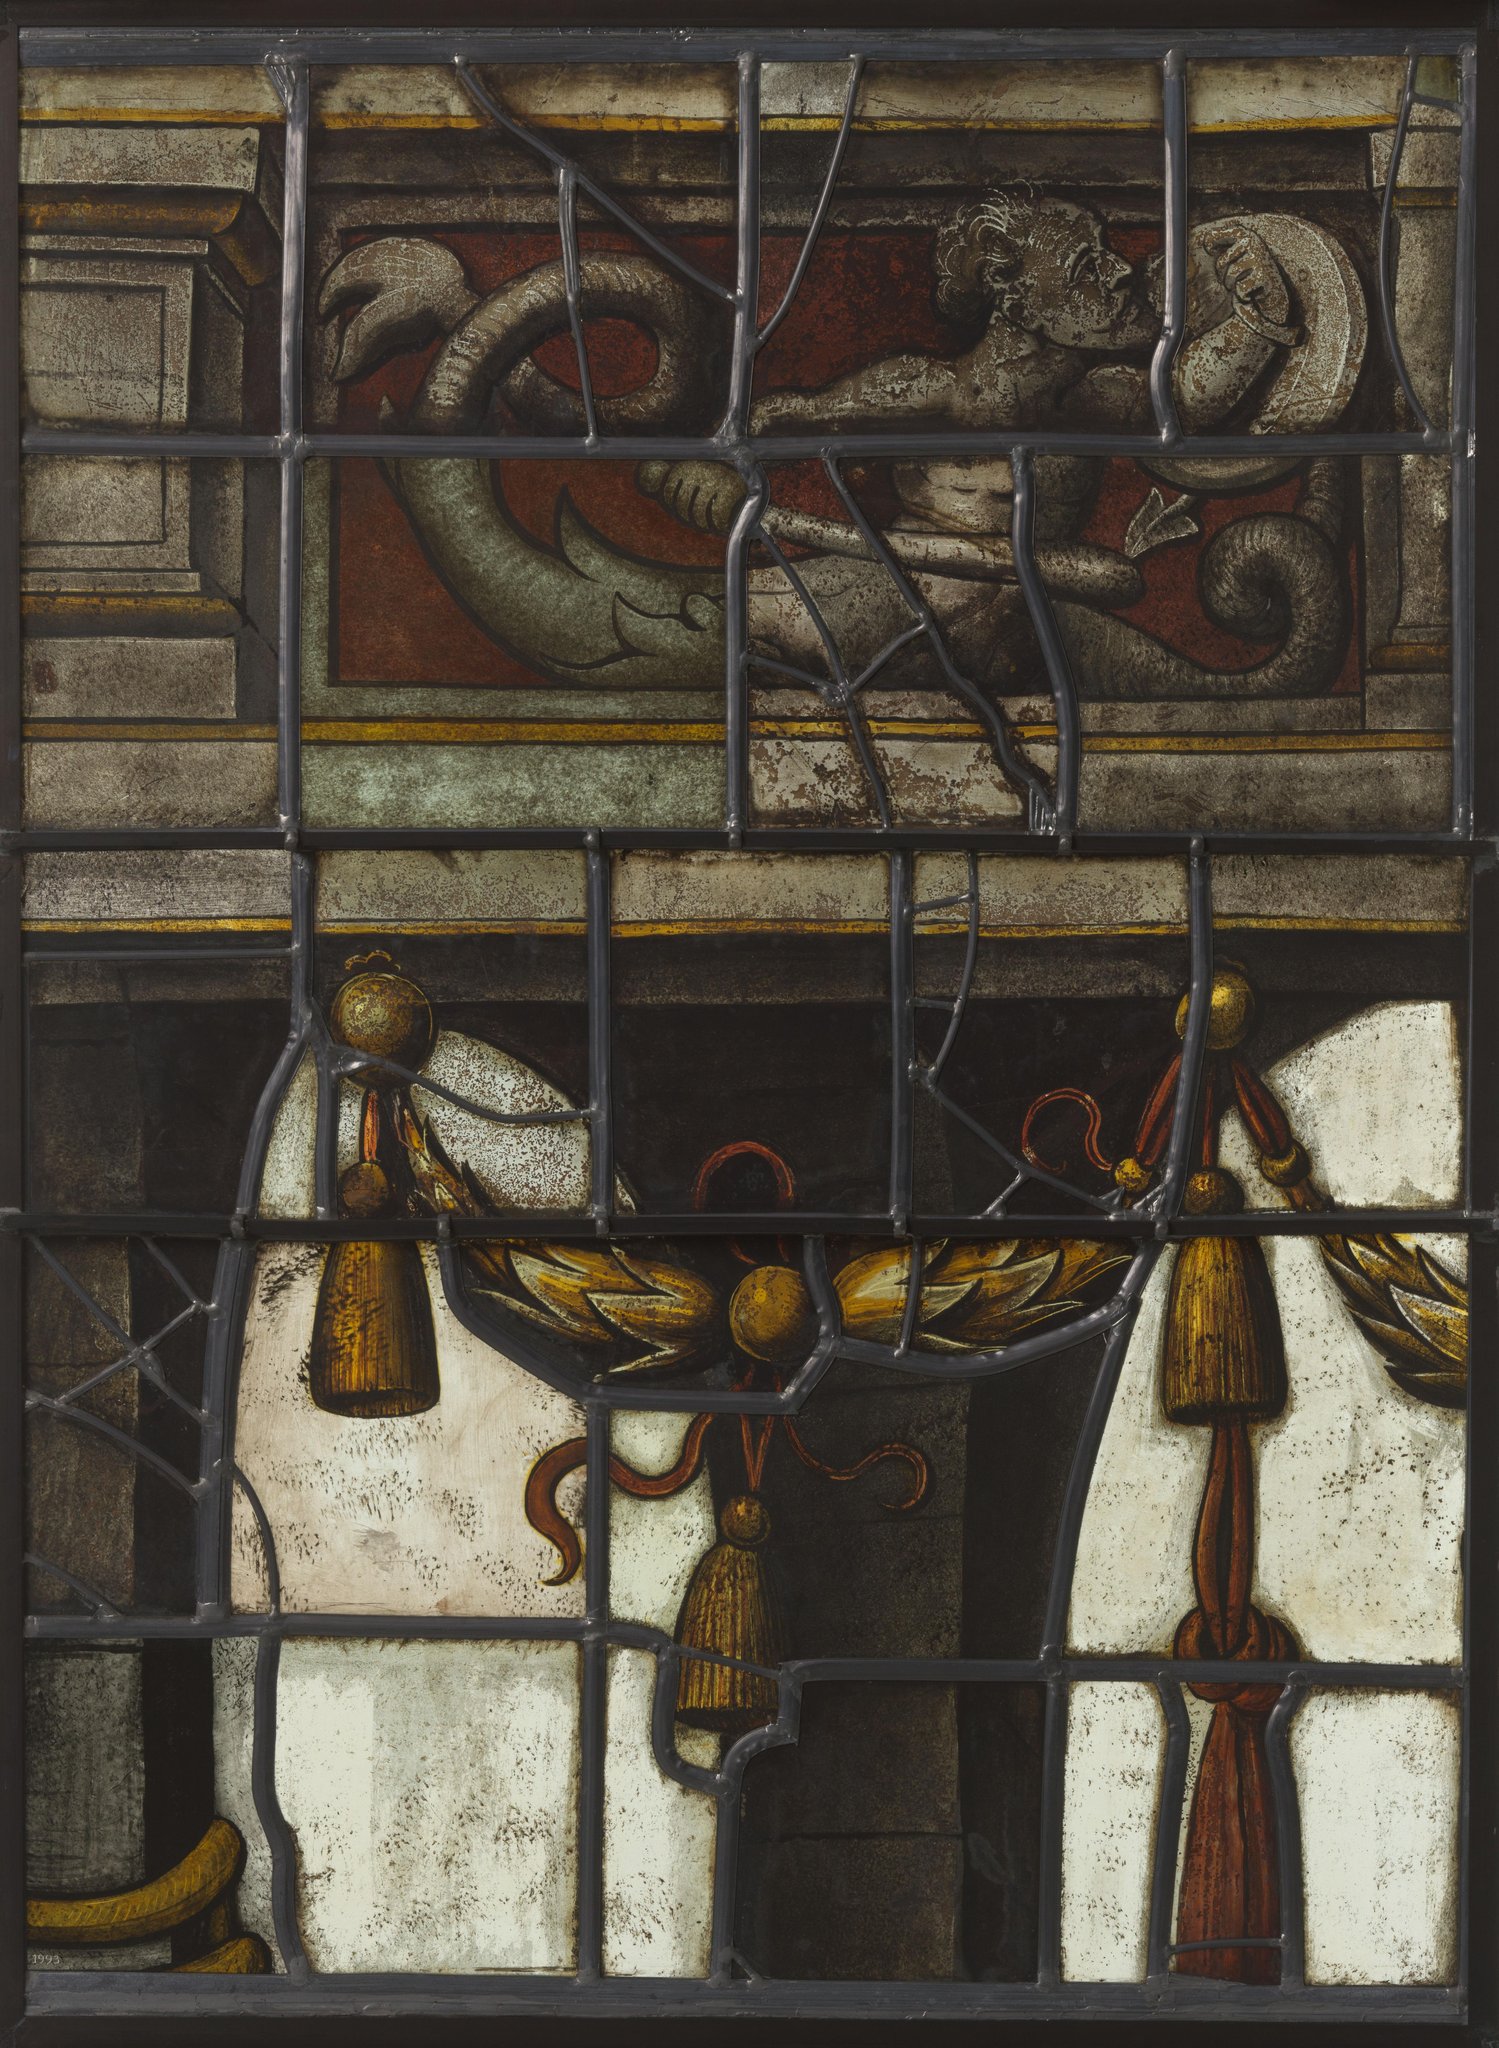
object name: light window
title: Tiende paneel van ruit met Prins Maurits in biddende houding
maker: Anonymous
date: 1618-1620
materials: glass, lead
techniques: leading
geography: netherlands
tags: the hague, maurice (prince of orange)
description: Groot raam afkomstig uit het klooster van St Agatha bij Cuyk. Prins Maurits in verguld harnas, met hermelijnen mantel en geplooide kraag, blootshoofds, in biddende houding, geknield op een bidstoel voor een lessenaar waarop een boek. De lessenaar staat op een tafel met een donkerblauw kleed met gouden franje gedekt. Helm en handschoenen liggen op de grond voor de tafel. De prins bevindt zich in een koepel door vier vrijstaande Korintische zuilen gedragen; boven zijn hoofd een baldakijn waaruit een lauwerkrans afhangt. De koepel wordt bekroond door het wapen van Maurits en het devies van de Orde van de Kousenband: 'Honi soit qui mal y pense' (Schande over hem die er kwaad van denkt). Wapen door twee lopende jongelingen gesteund. Het wapen leunt tegen het bovenstuk van de koepel. Onder dit tafereel bevinden zich brokstukken architectuur die onoordeelkundig zijn aangebracht. Rechts ligt een jonge vrouw geknield met opgeheven handen. Zij draagt een geel zijden mantel met hermelijn omzoomd. Het gezicht is in olieverf bijgemaakt in 1891.